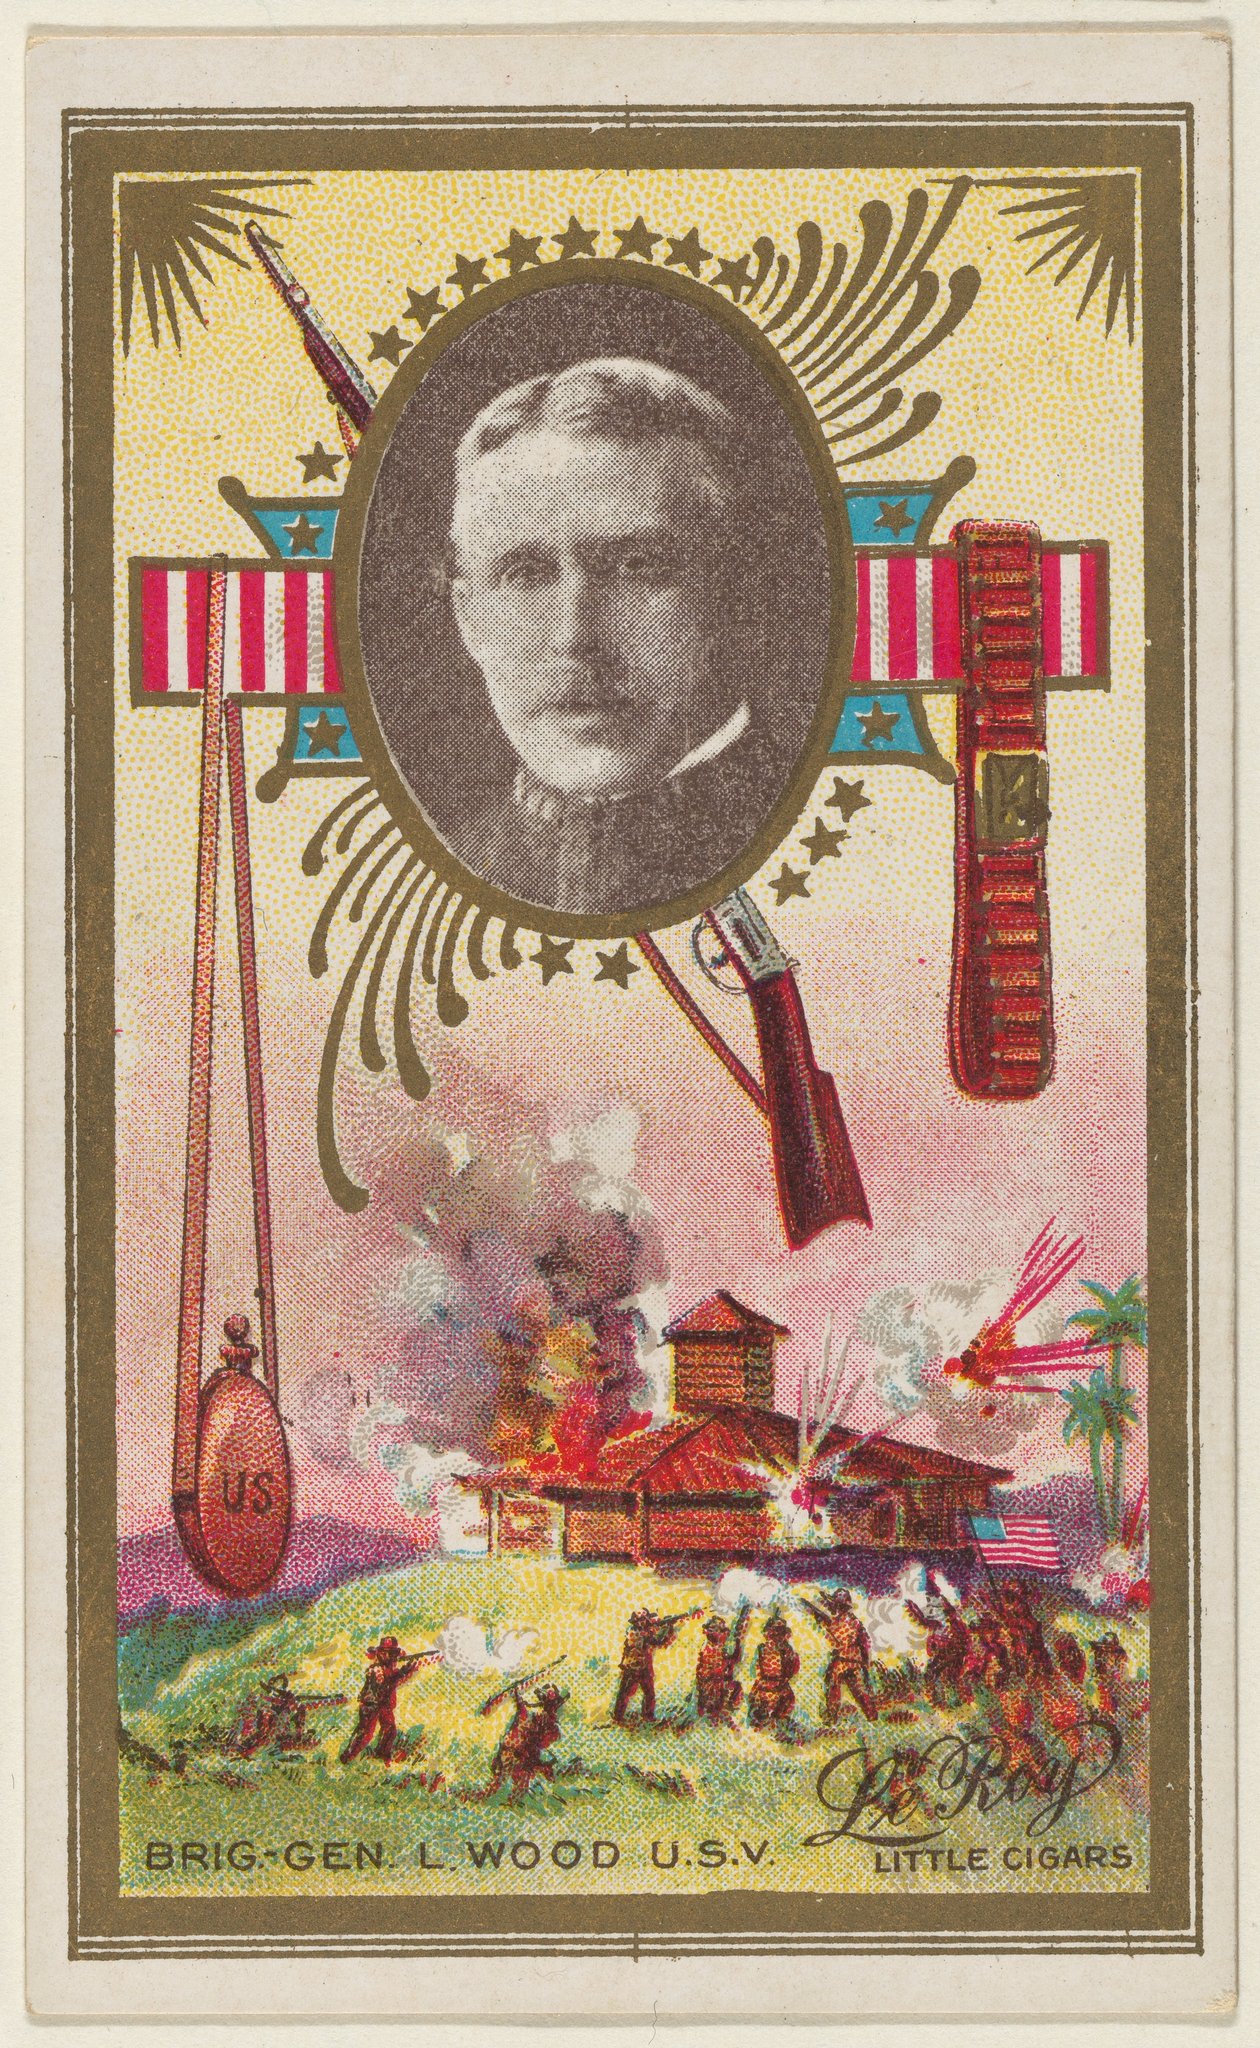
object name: print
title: Brigadier General Leonard Wood, U.S. Volunteers, from the "Generals" series (T63), issued by LeRoy Little Cigars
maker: leroy little cigars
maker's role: publisher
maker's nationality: american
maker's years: 1850-1950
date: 1898-1901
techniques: color lithograph